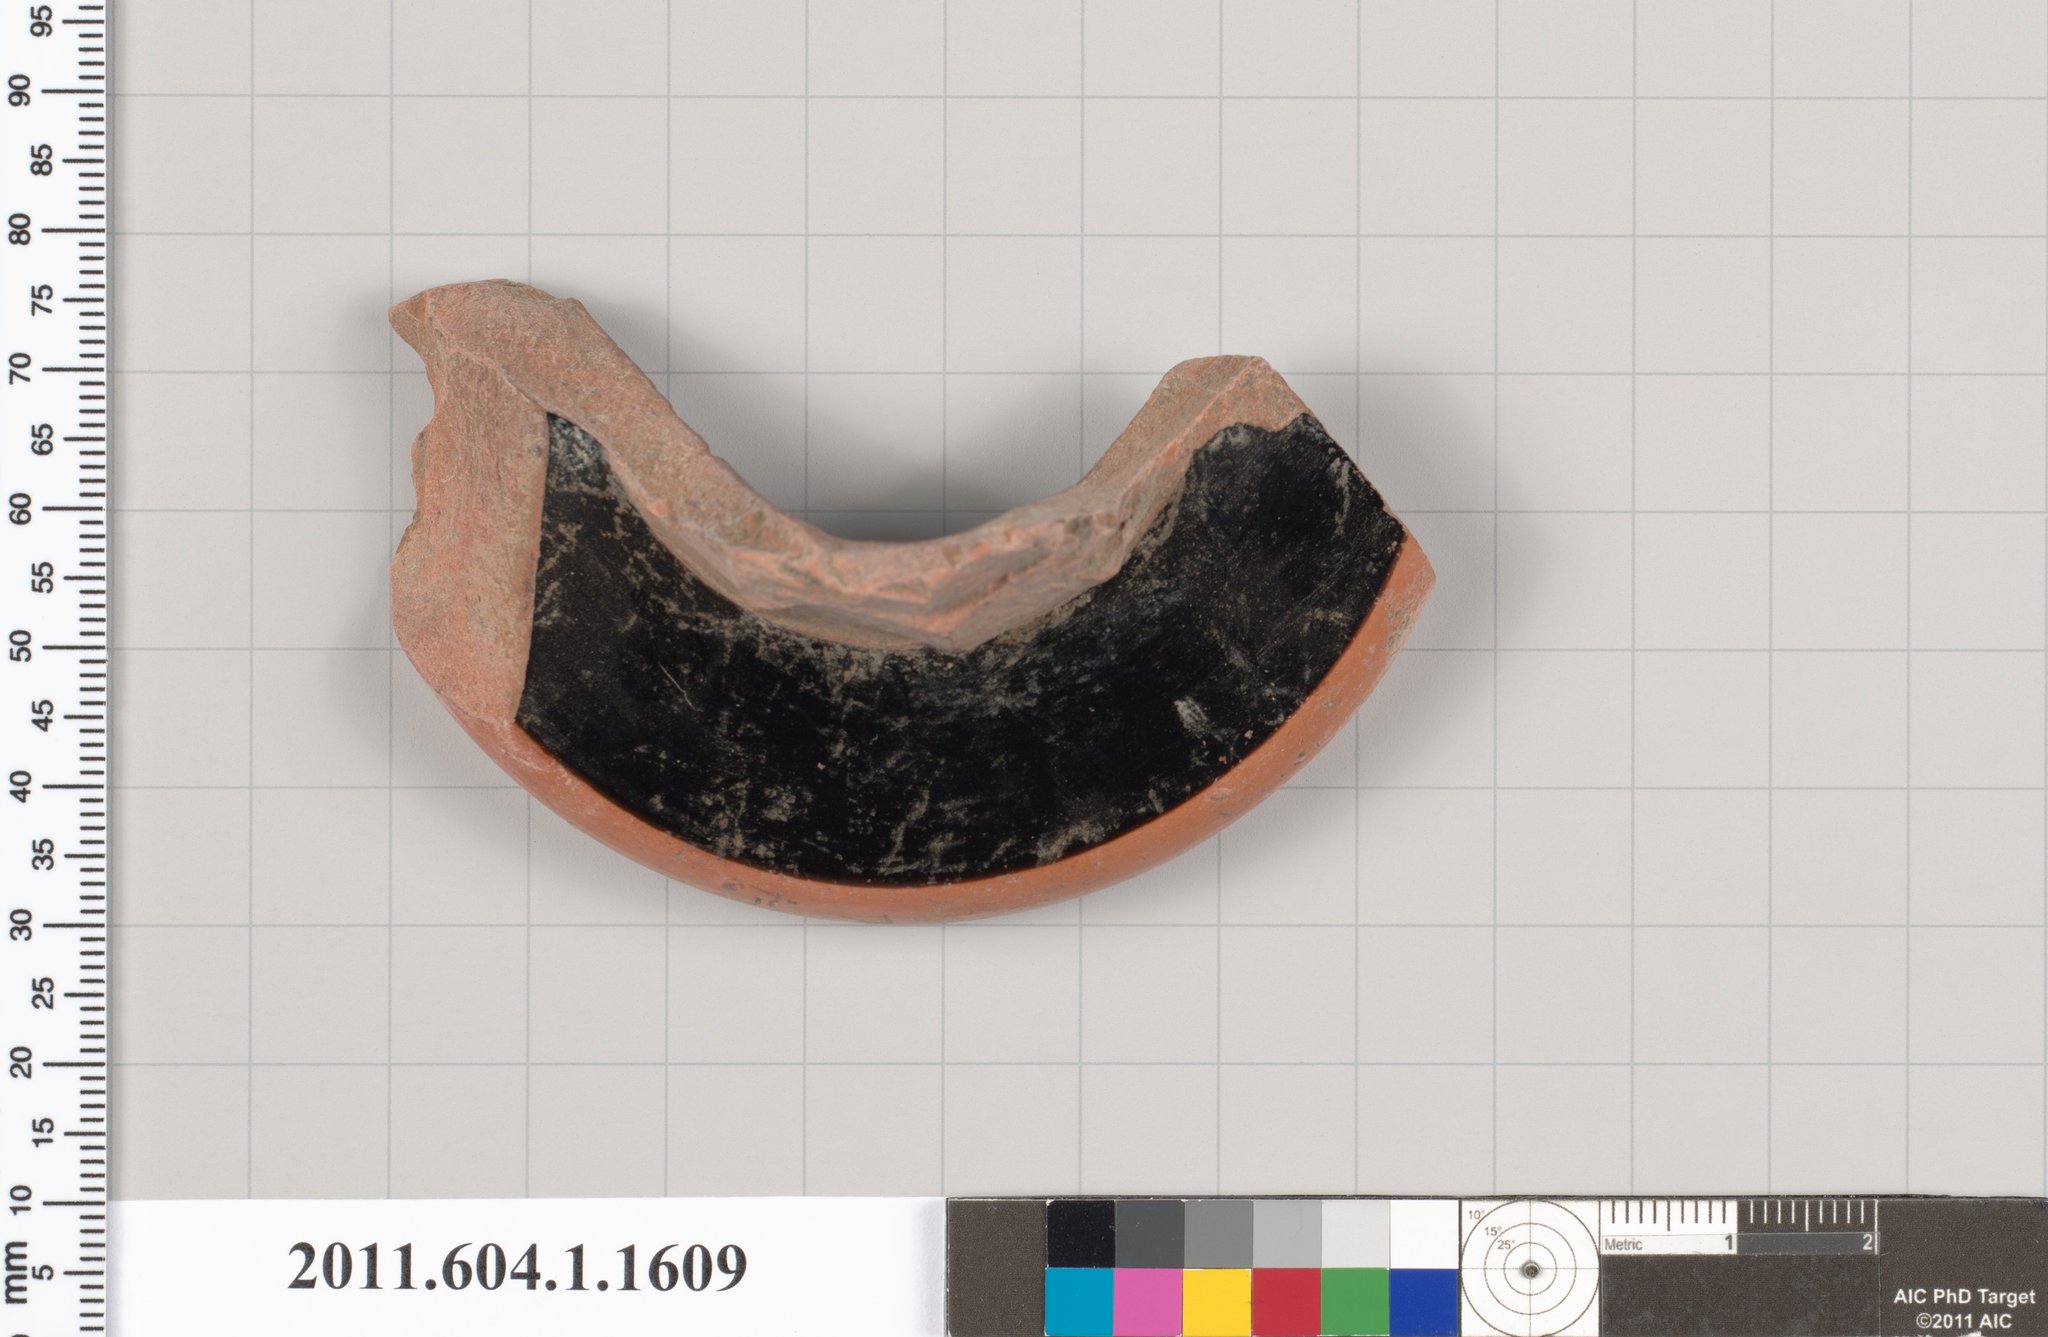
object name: kylix fragment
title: Terracotta fragment of a kylix (drinking cup)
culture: greek, attic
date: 500-401 BCE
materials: terracotta